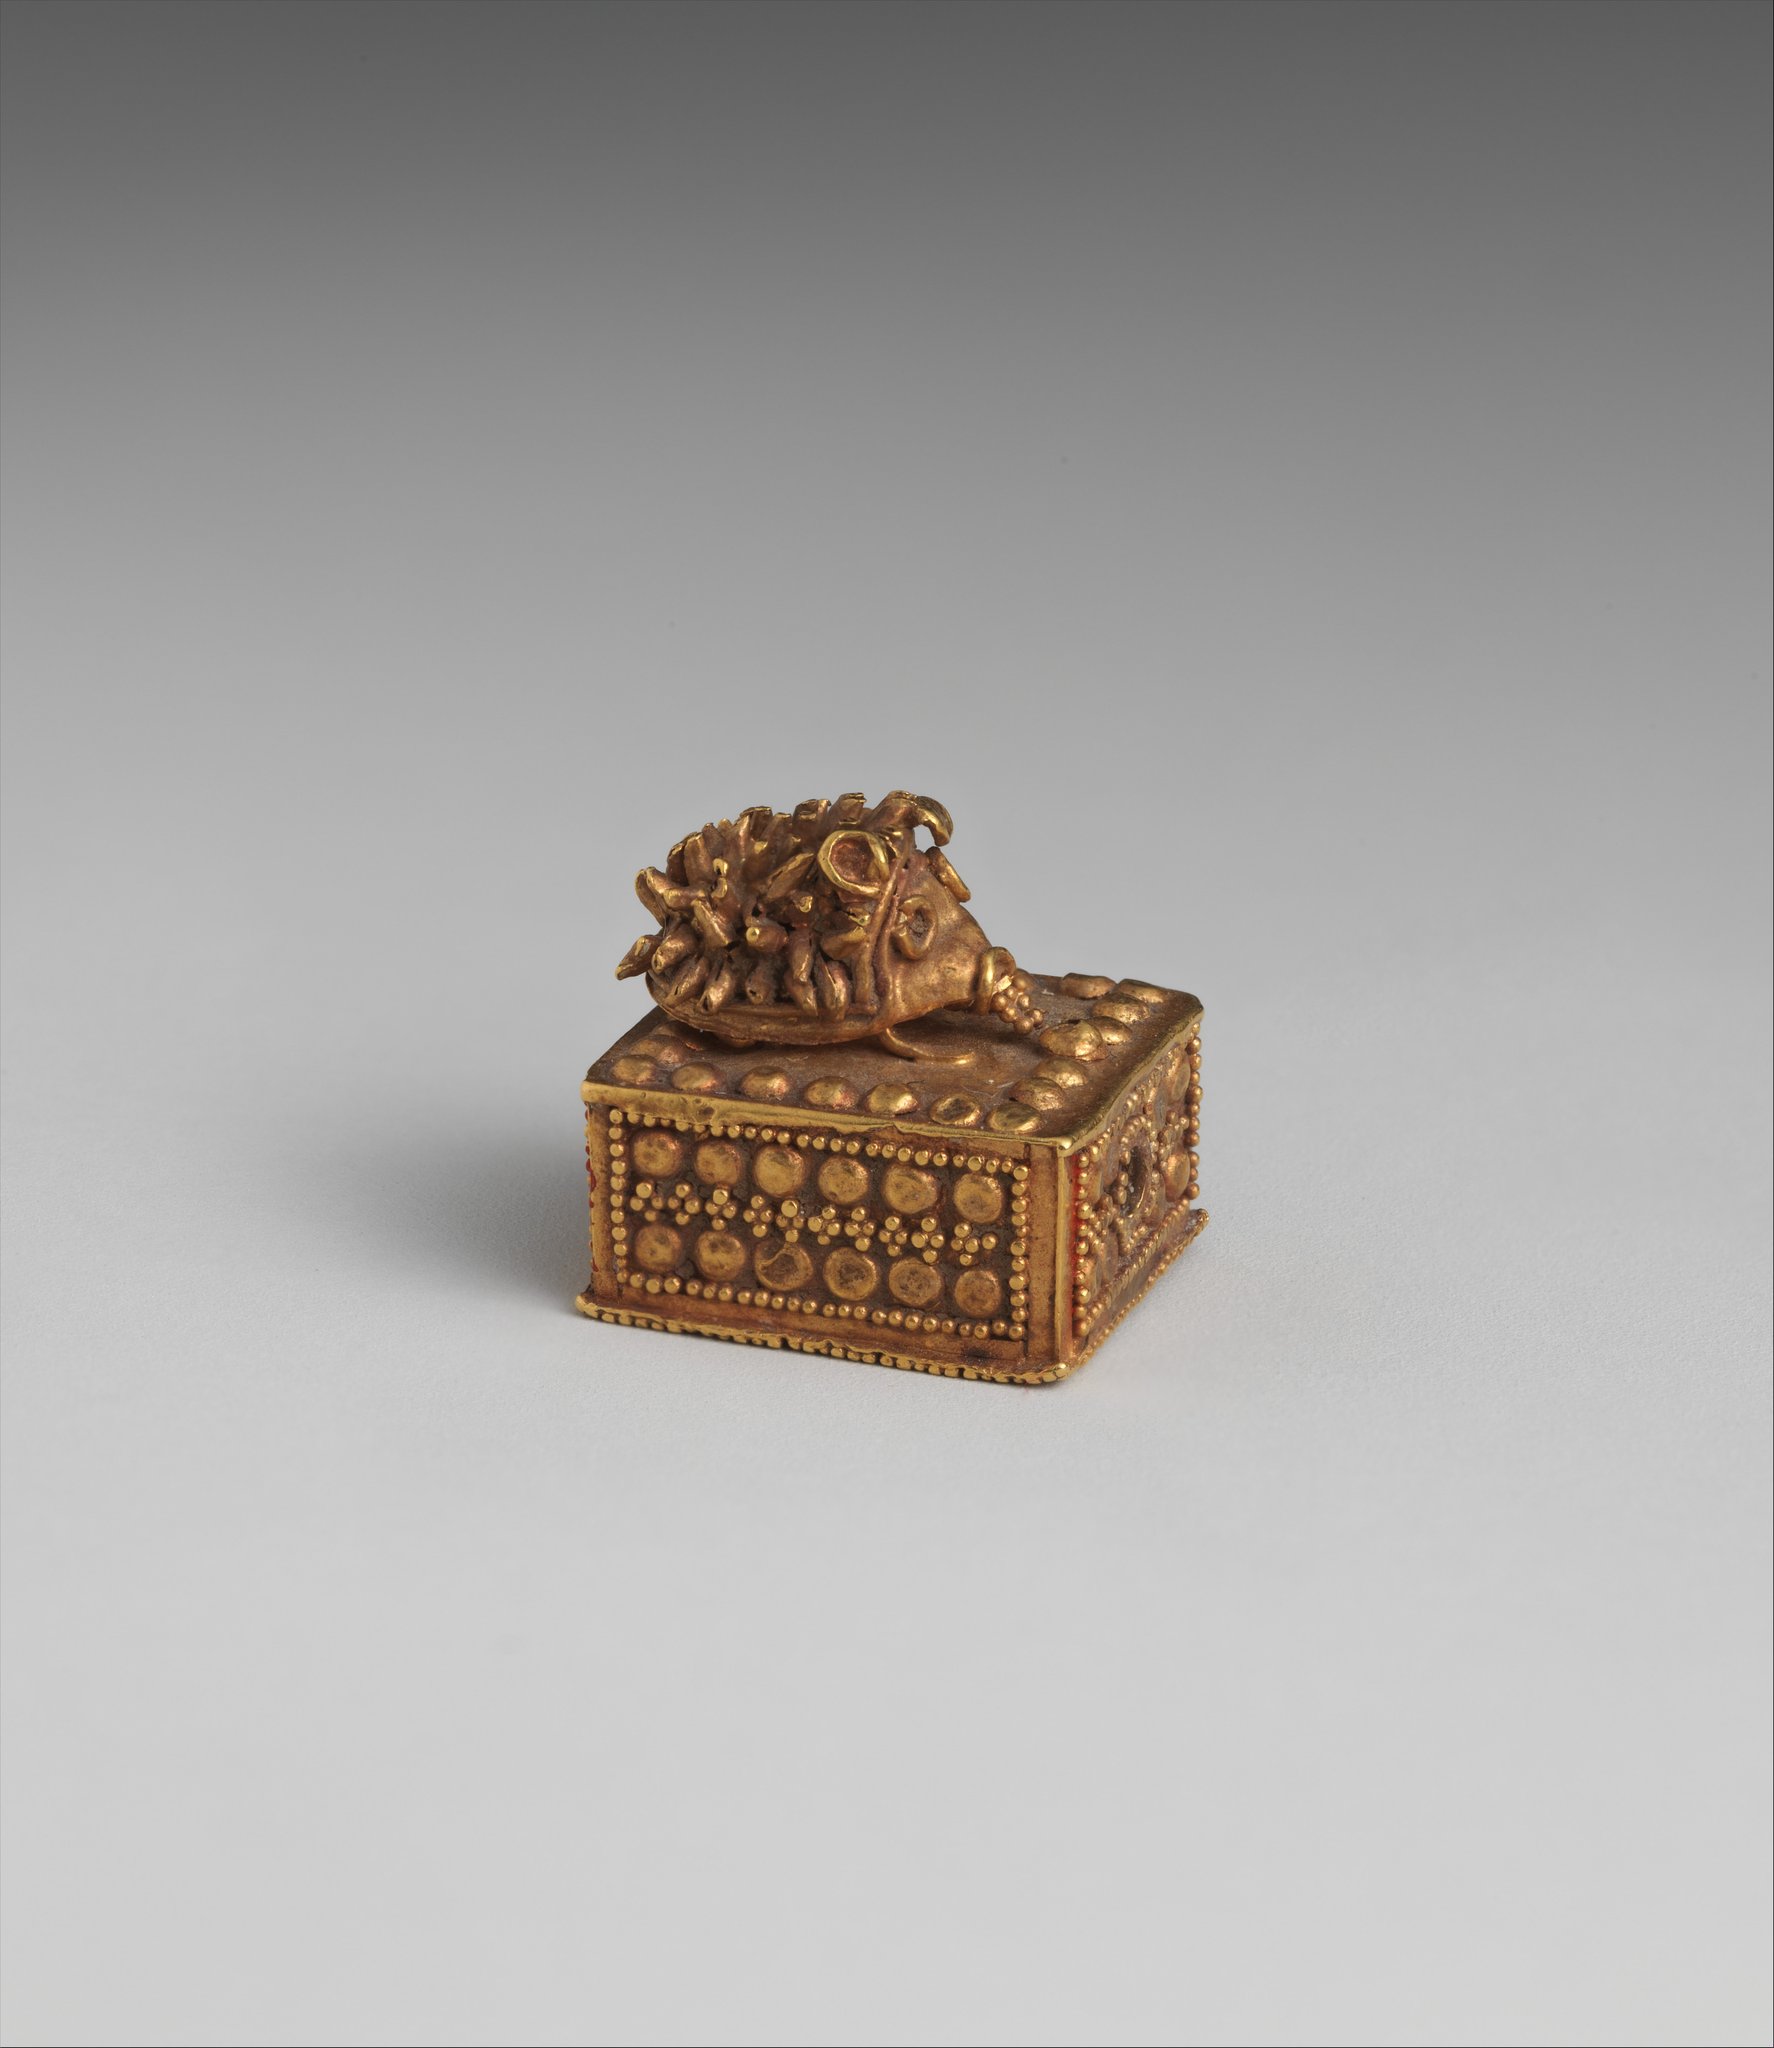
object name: pendant, hedgehog on box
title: Hedgehog on box pendant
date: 301-400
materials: gold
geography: egypt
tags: animals